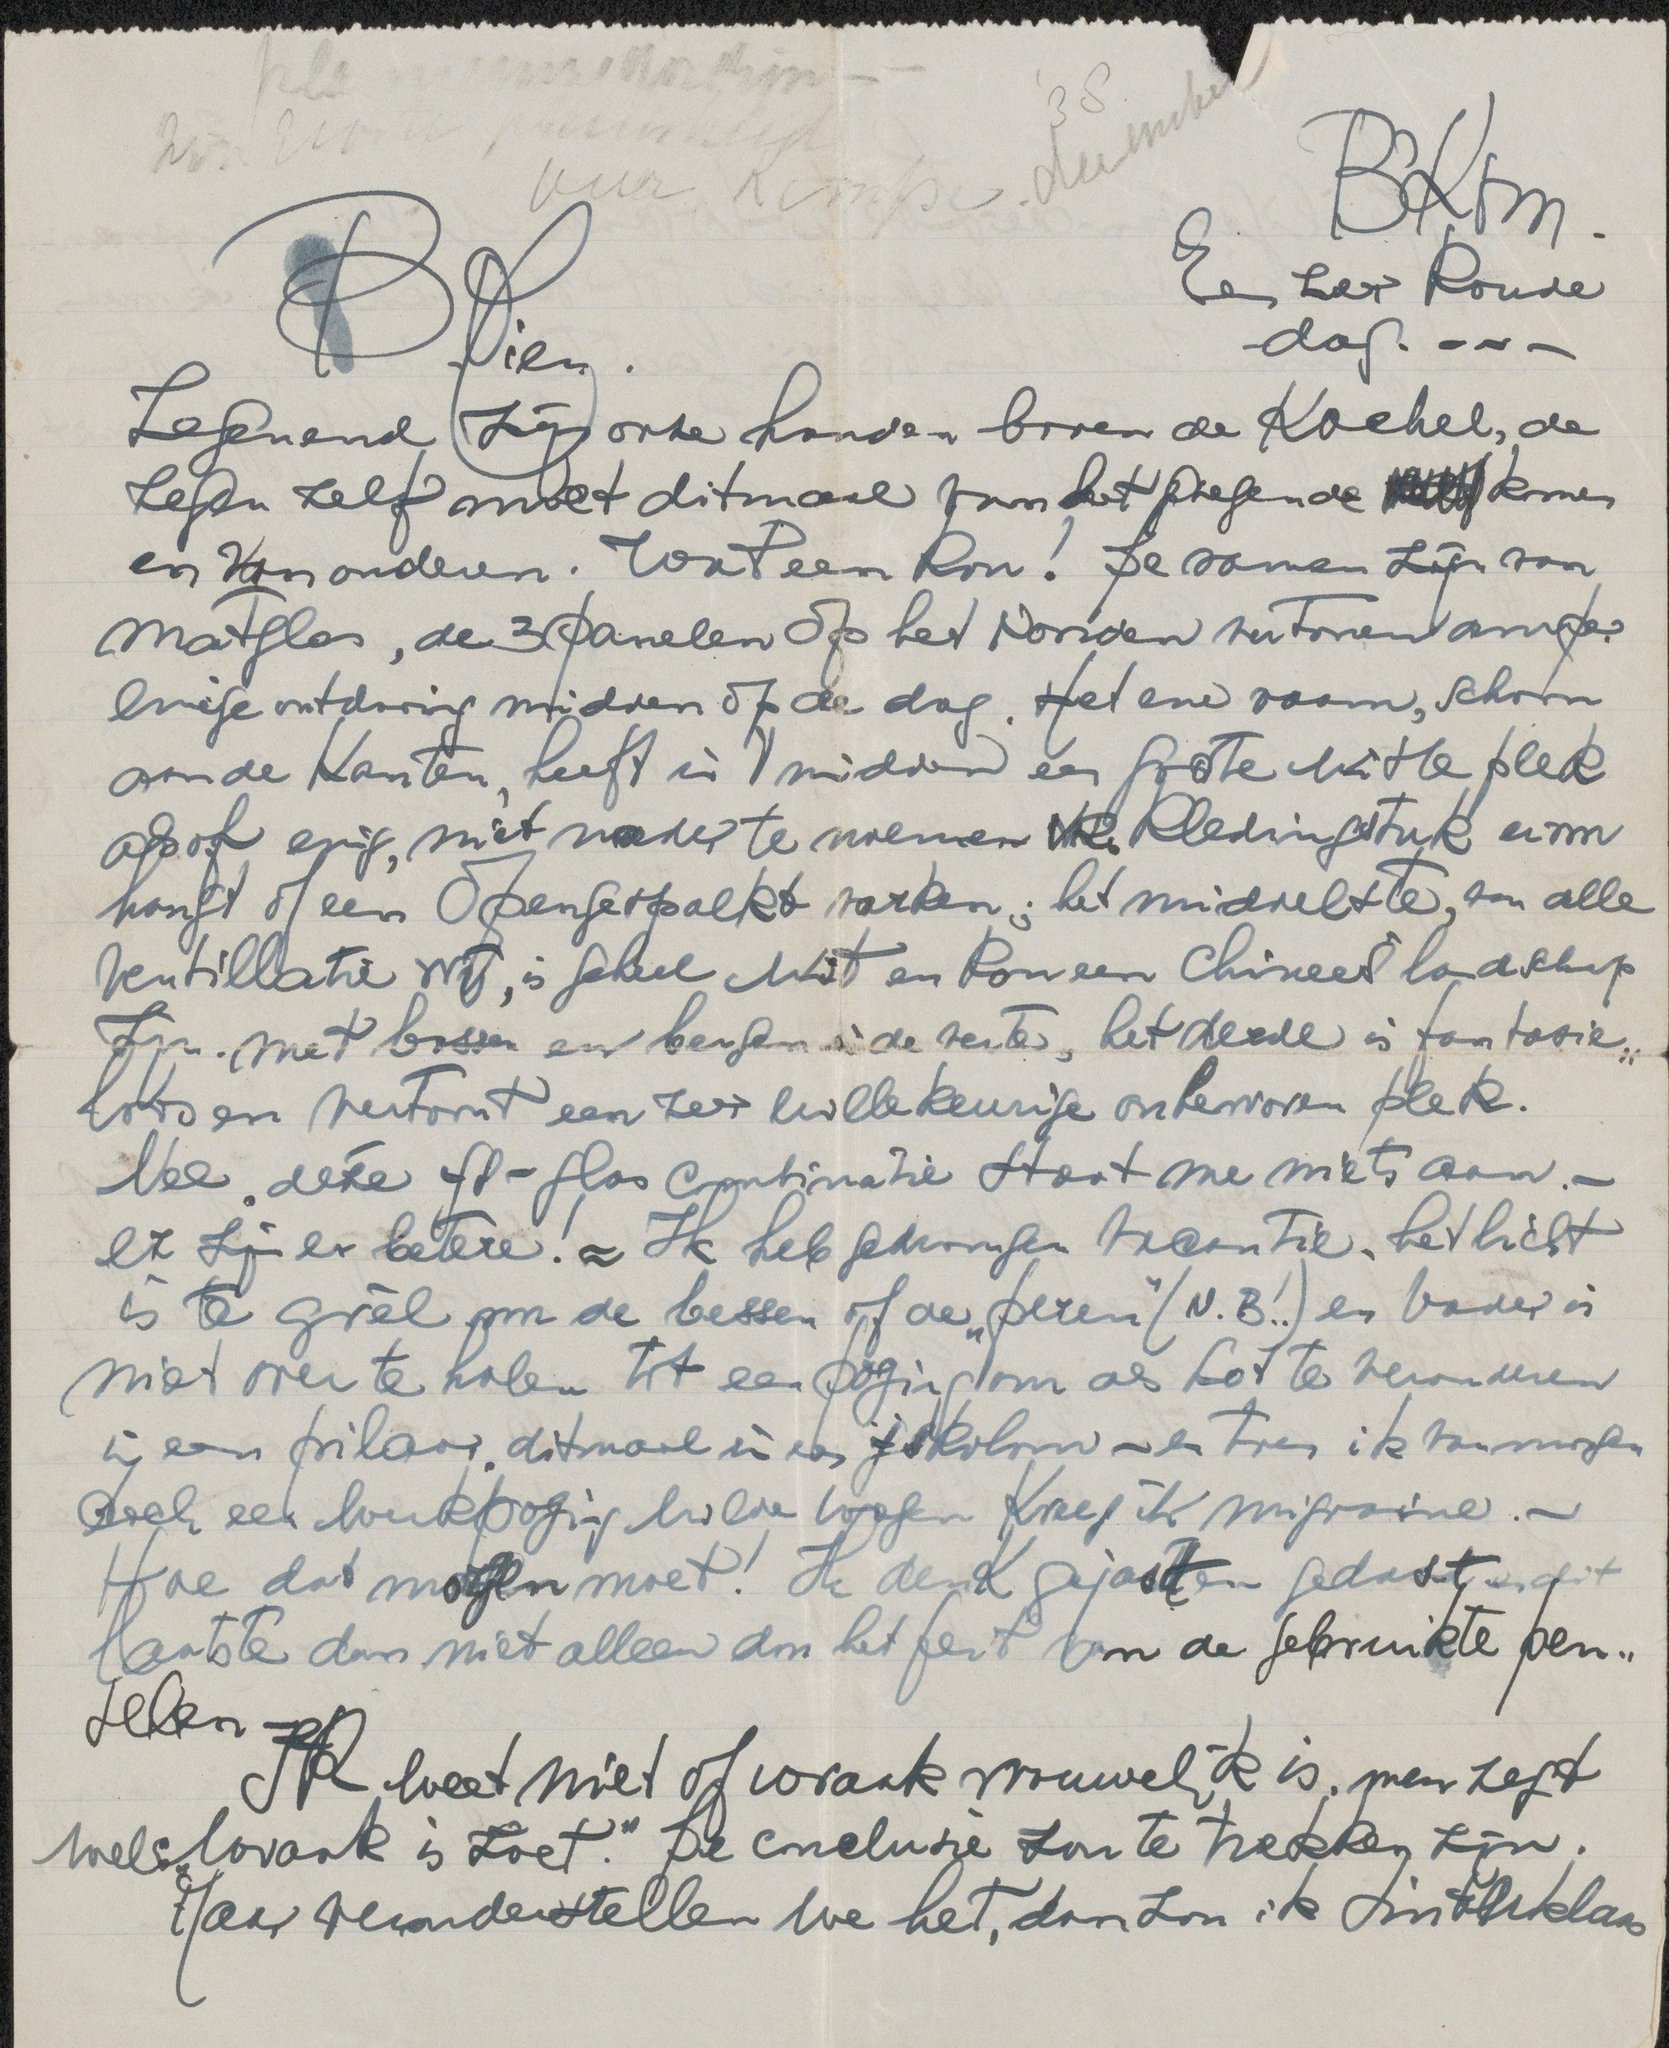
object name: letter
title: Brief aan Mien Cambier van Nooten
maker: dick ket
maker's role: draughtsman, print maker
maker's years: 1902-1940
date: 1912-1940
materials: ink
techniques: pen, writing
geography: bennekom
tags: arnhem, mien cambier van nooten, jeanne bieruma oosting, dirk van gelder, exhibition ~ art, diseases, new york (city)